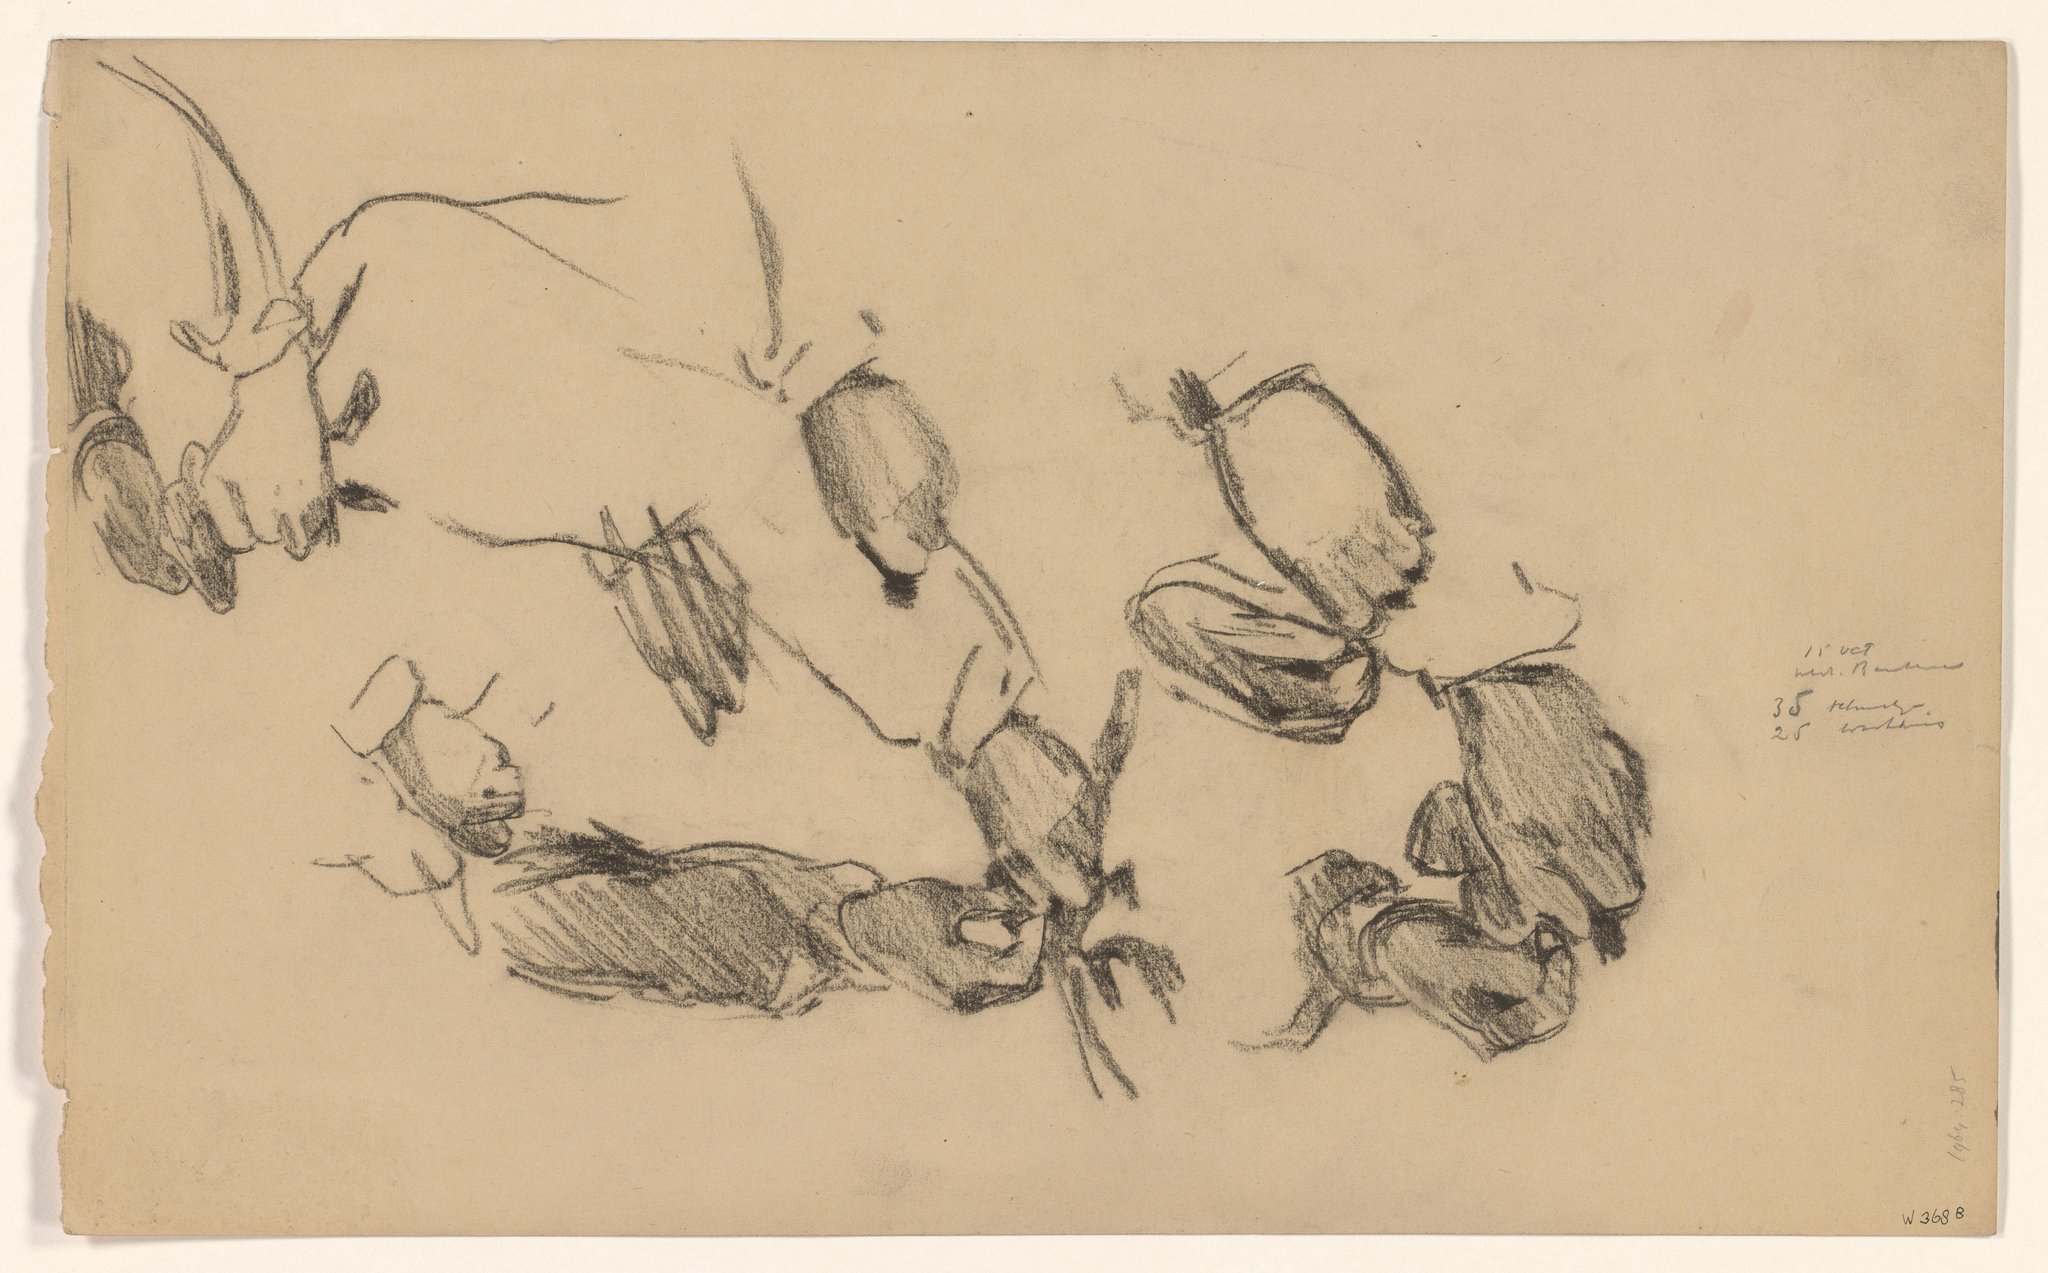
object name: drawing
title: Composities van handen voor De Molenaar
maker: willem witsen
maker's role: draughtsman, painter, print maker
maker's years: 1860-1923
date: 1870-1923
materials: chalk, paper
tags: miller, hand